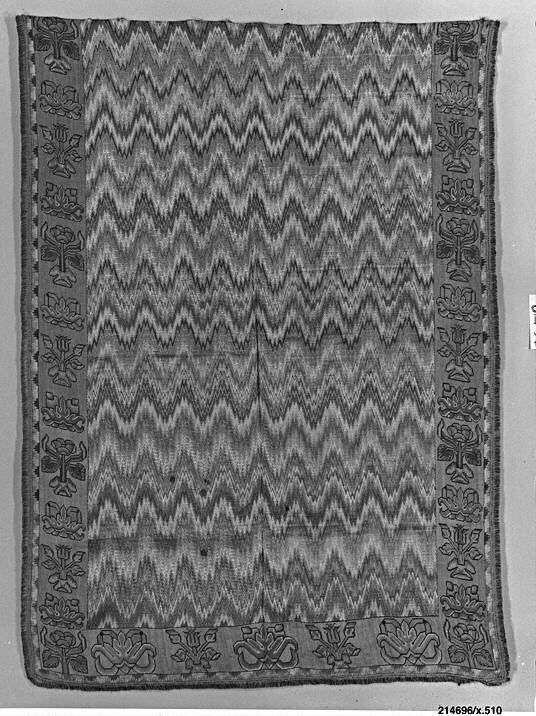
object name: panel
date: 1601-1700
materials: canvas, silk